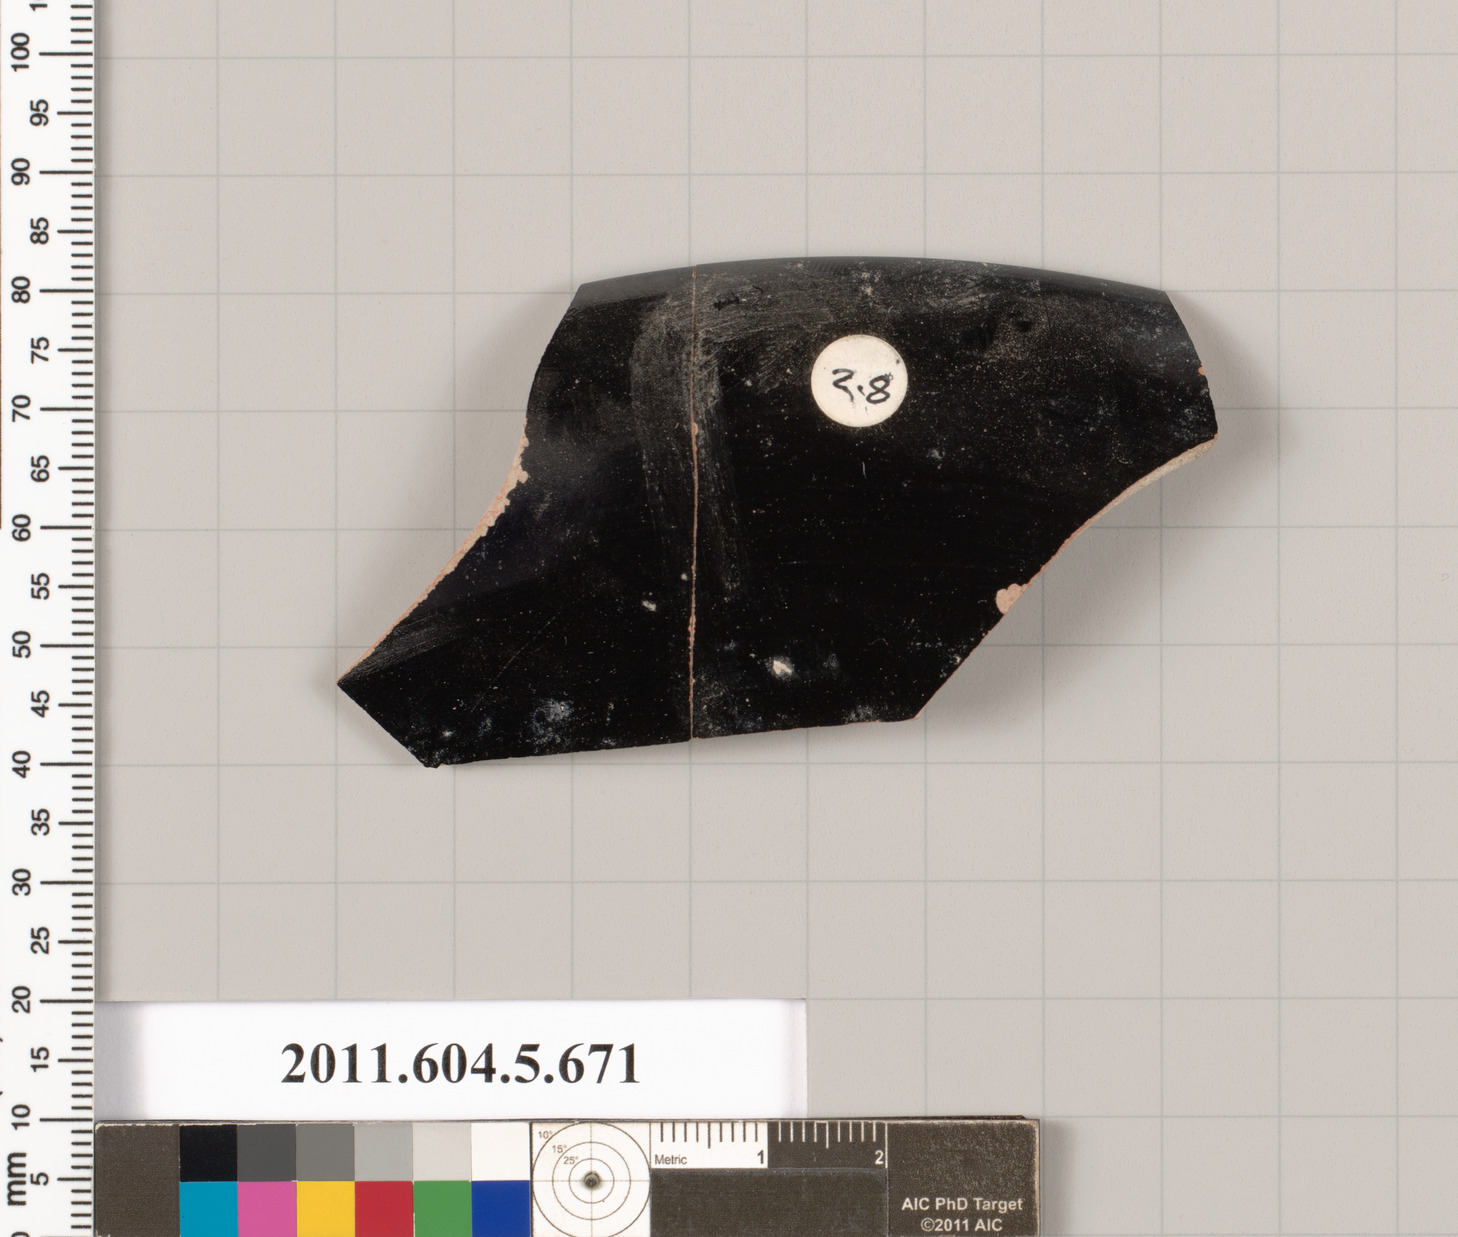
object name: kylix fragment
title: Terracotta rim fragment of a kylix (drinking cup)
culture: greek, attic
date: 600-401 BCE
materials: terracotta